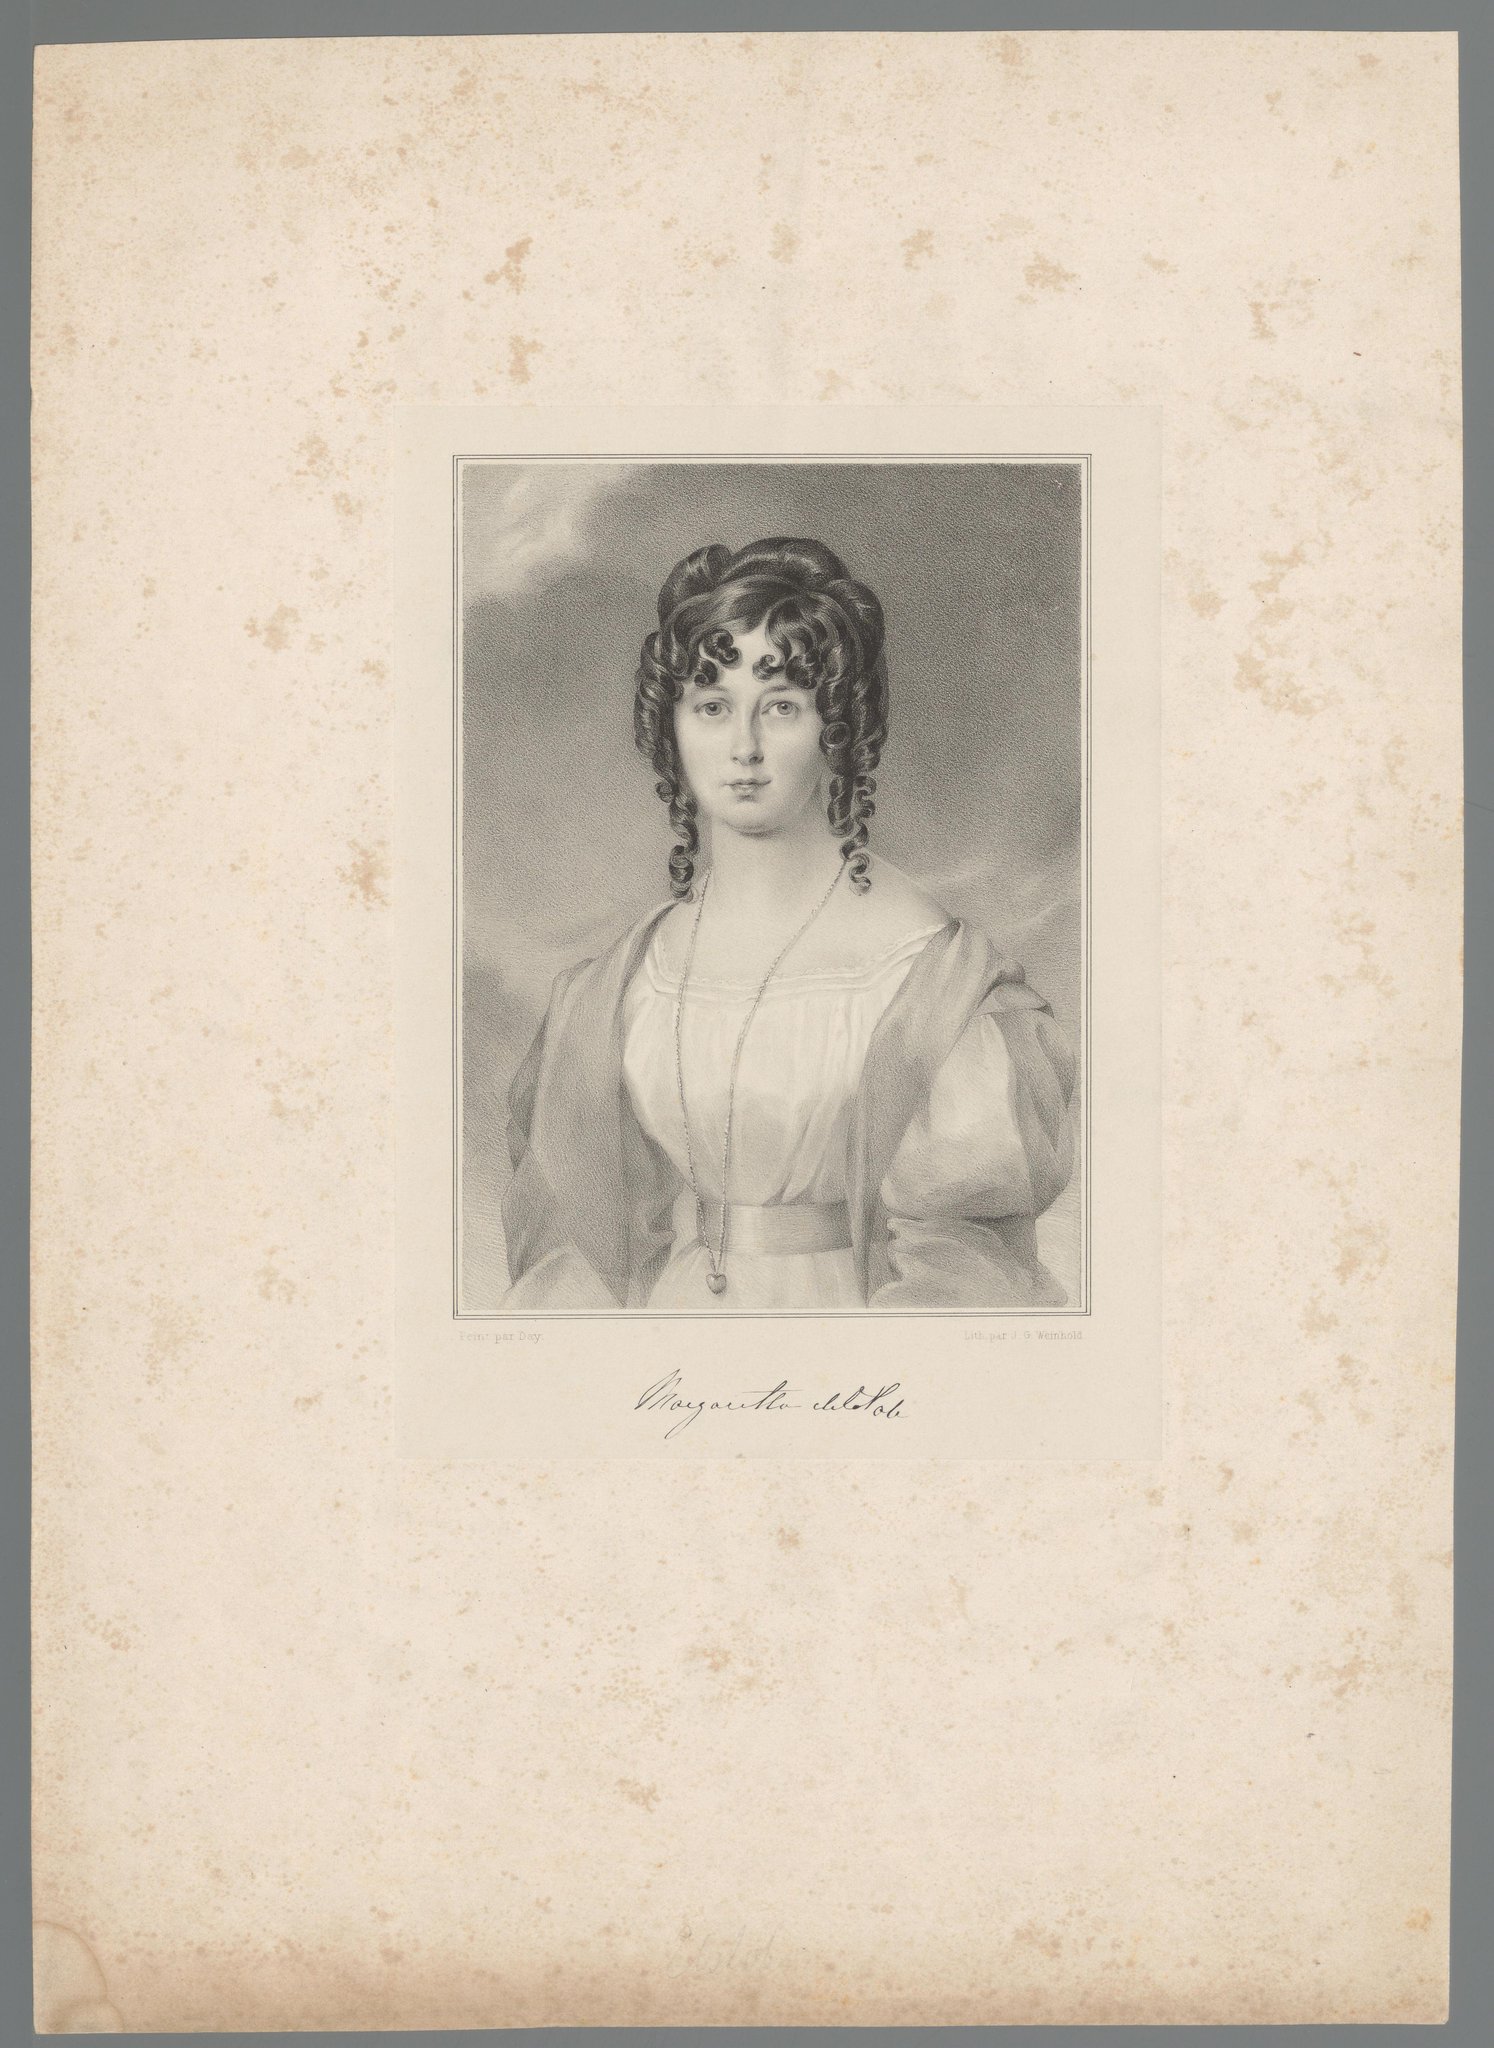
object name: print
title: Portret van een onbekende vrouw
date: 1823-1880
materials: paper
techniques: lithograph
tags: adolescent, young woman, maiden, historical persons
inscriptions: collector's mark: Lugt 2228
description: Portret van een verder onbekende vrouw, met de naam Margaretha. Signatuur in facsimile.